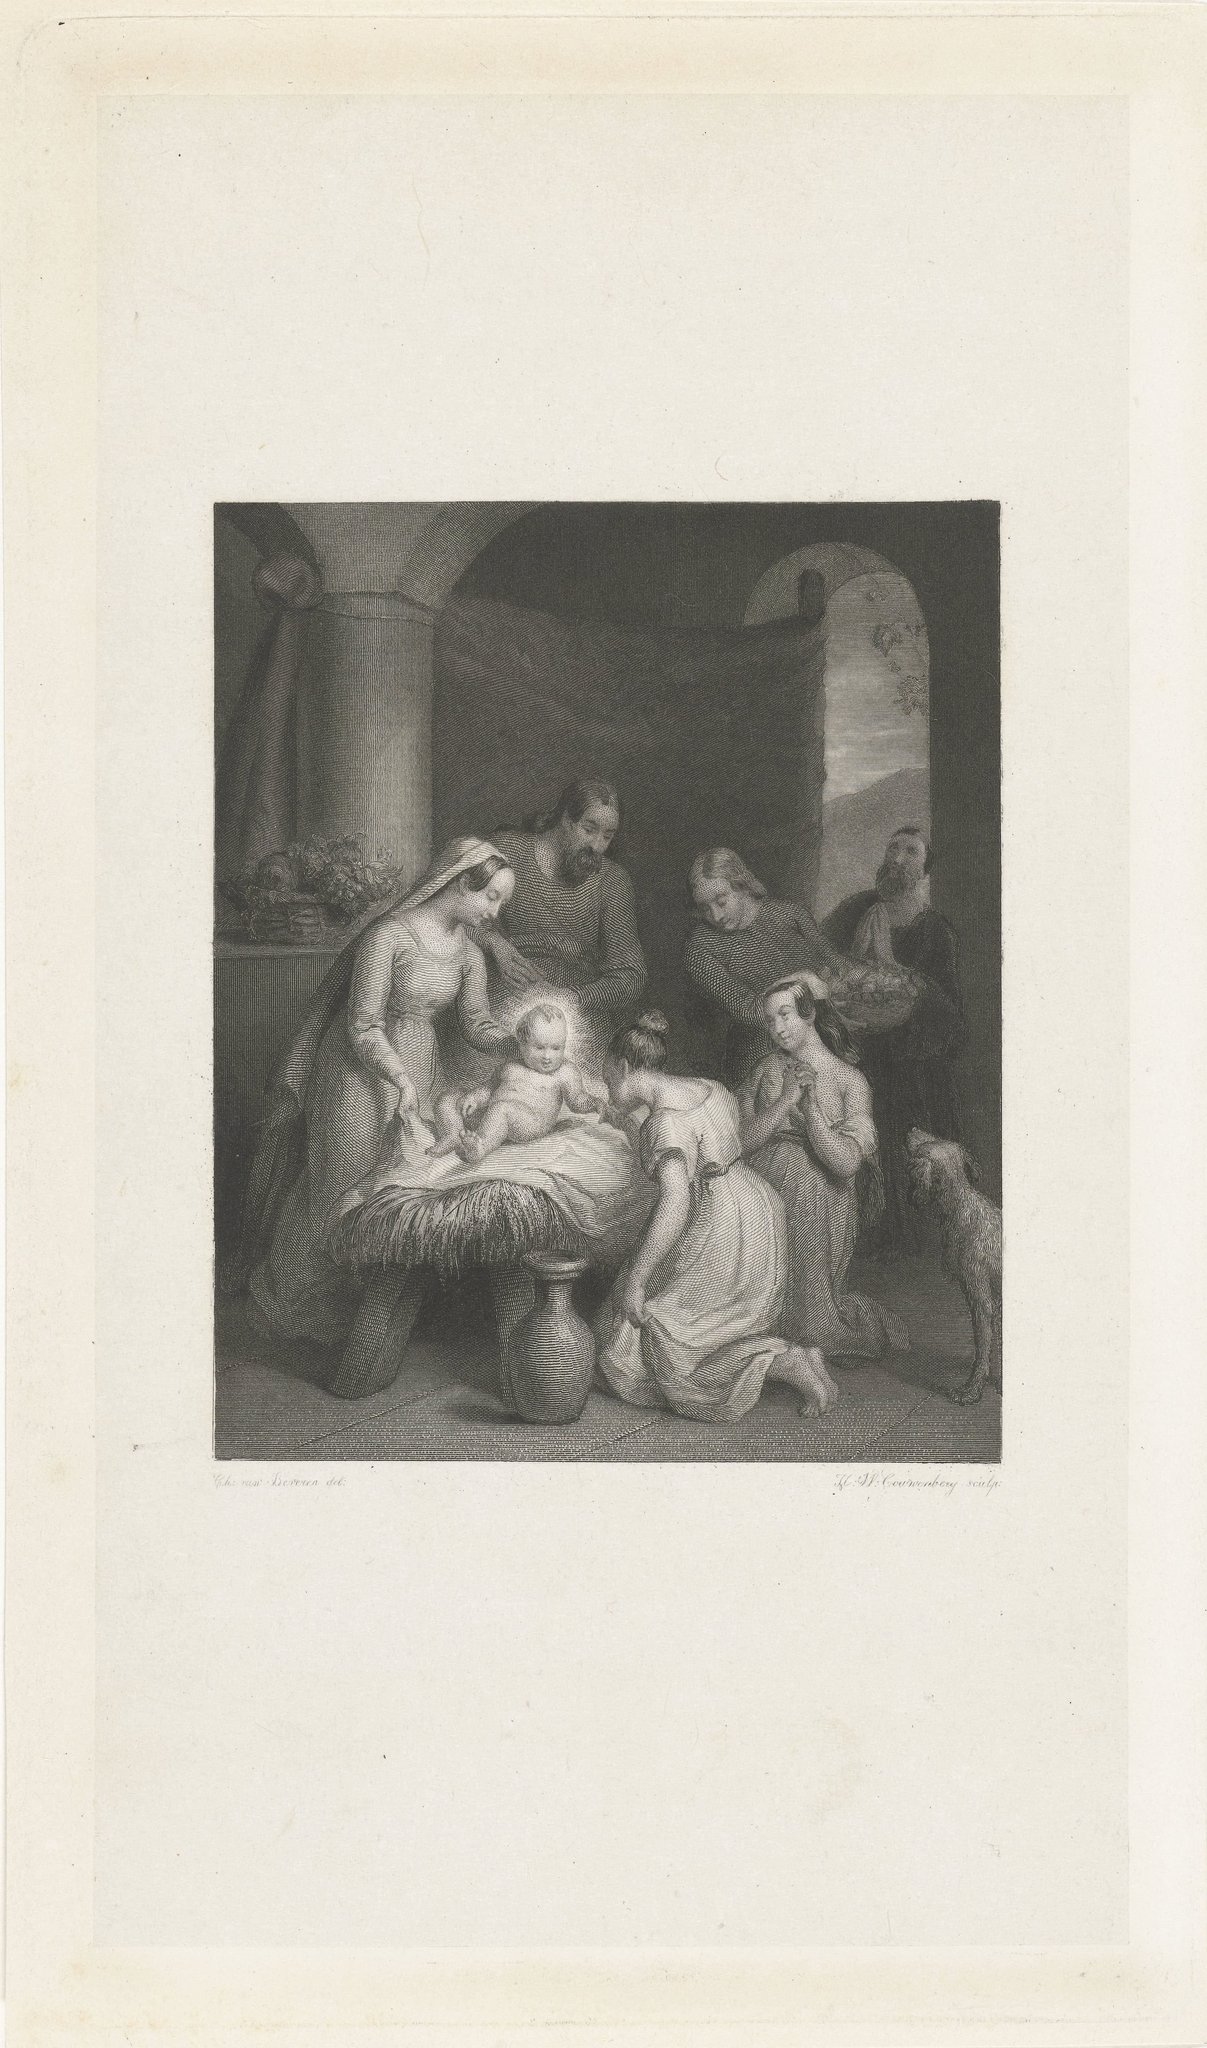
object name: book illustration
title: Aanbidding van het Kind door twee herdersmeisjes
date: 1830-1845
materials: paper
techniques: engraving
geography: amsterdam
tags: adoration of the christ-child by the shepherds; mary and joseph present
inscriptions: collector's mark: Lugt 2228